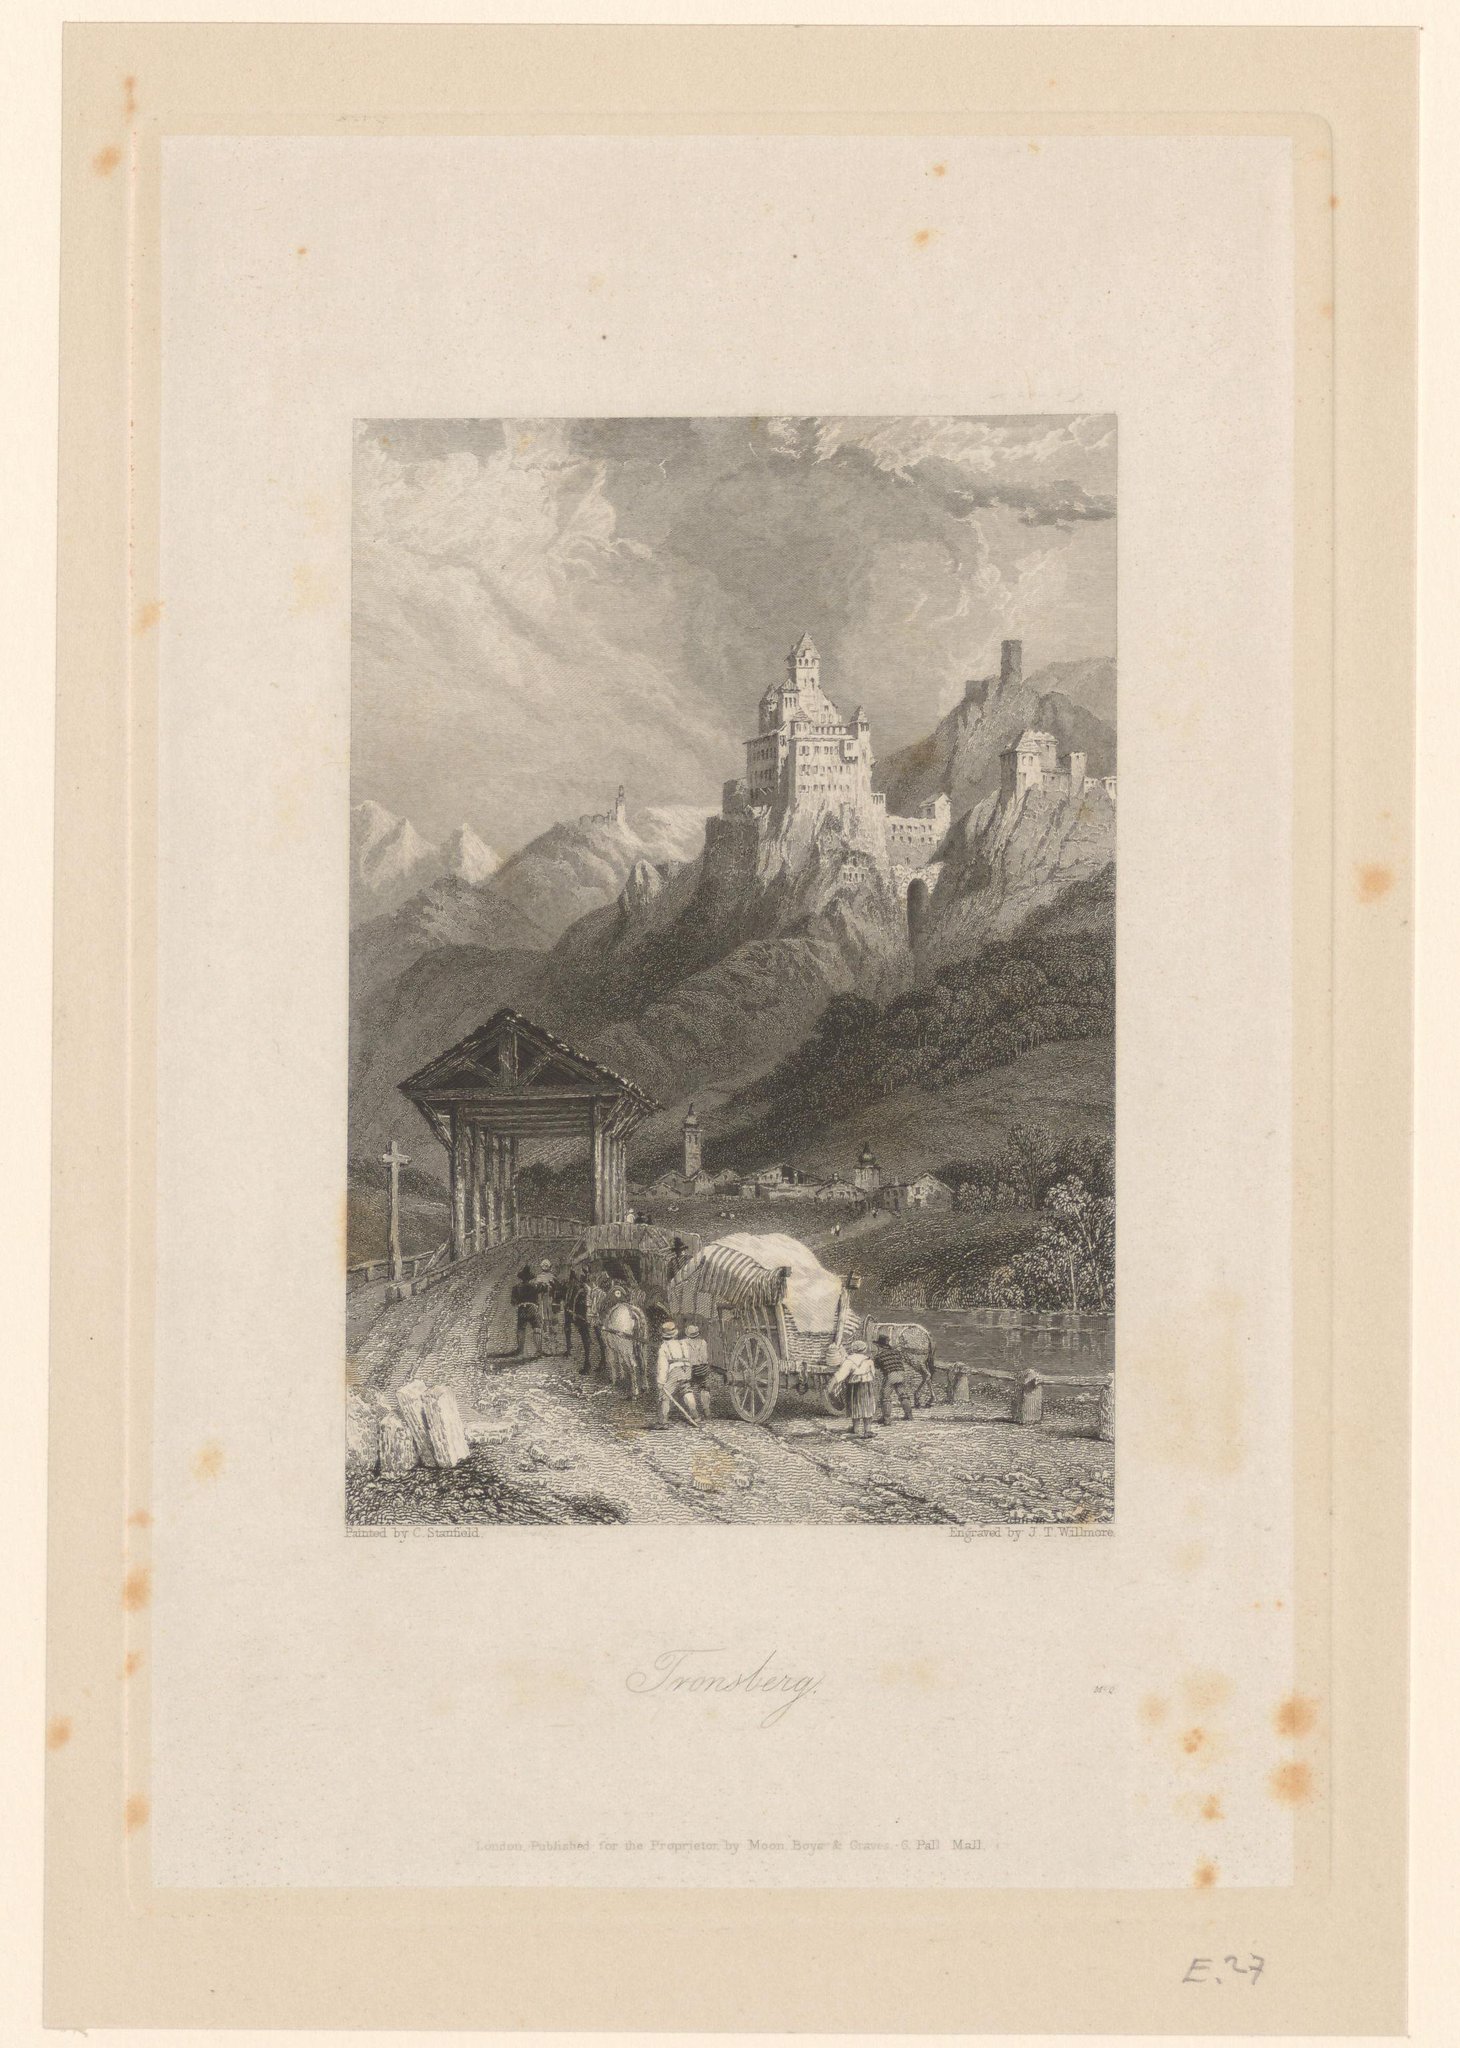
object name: print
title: Tronsberg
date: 1832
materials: paper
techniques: etching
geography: london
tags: animal traction, animal-drawn vehicle (carriage etc.), landscape with tower or castle, mountains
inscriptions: collector's mark: Lugt 2228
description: Andere staat gebruikt in: Ritchie, Leitch. Heath's Picturesque Annual. Travelling Sketches in the North of Italy, the Tyrol, and on the Rhine. Londen: Longman, Rees, Orme, Brown & Green, 1832.